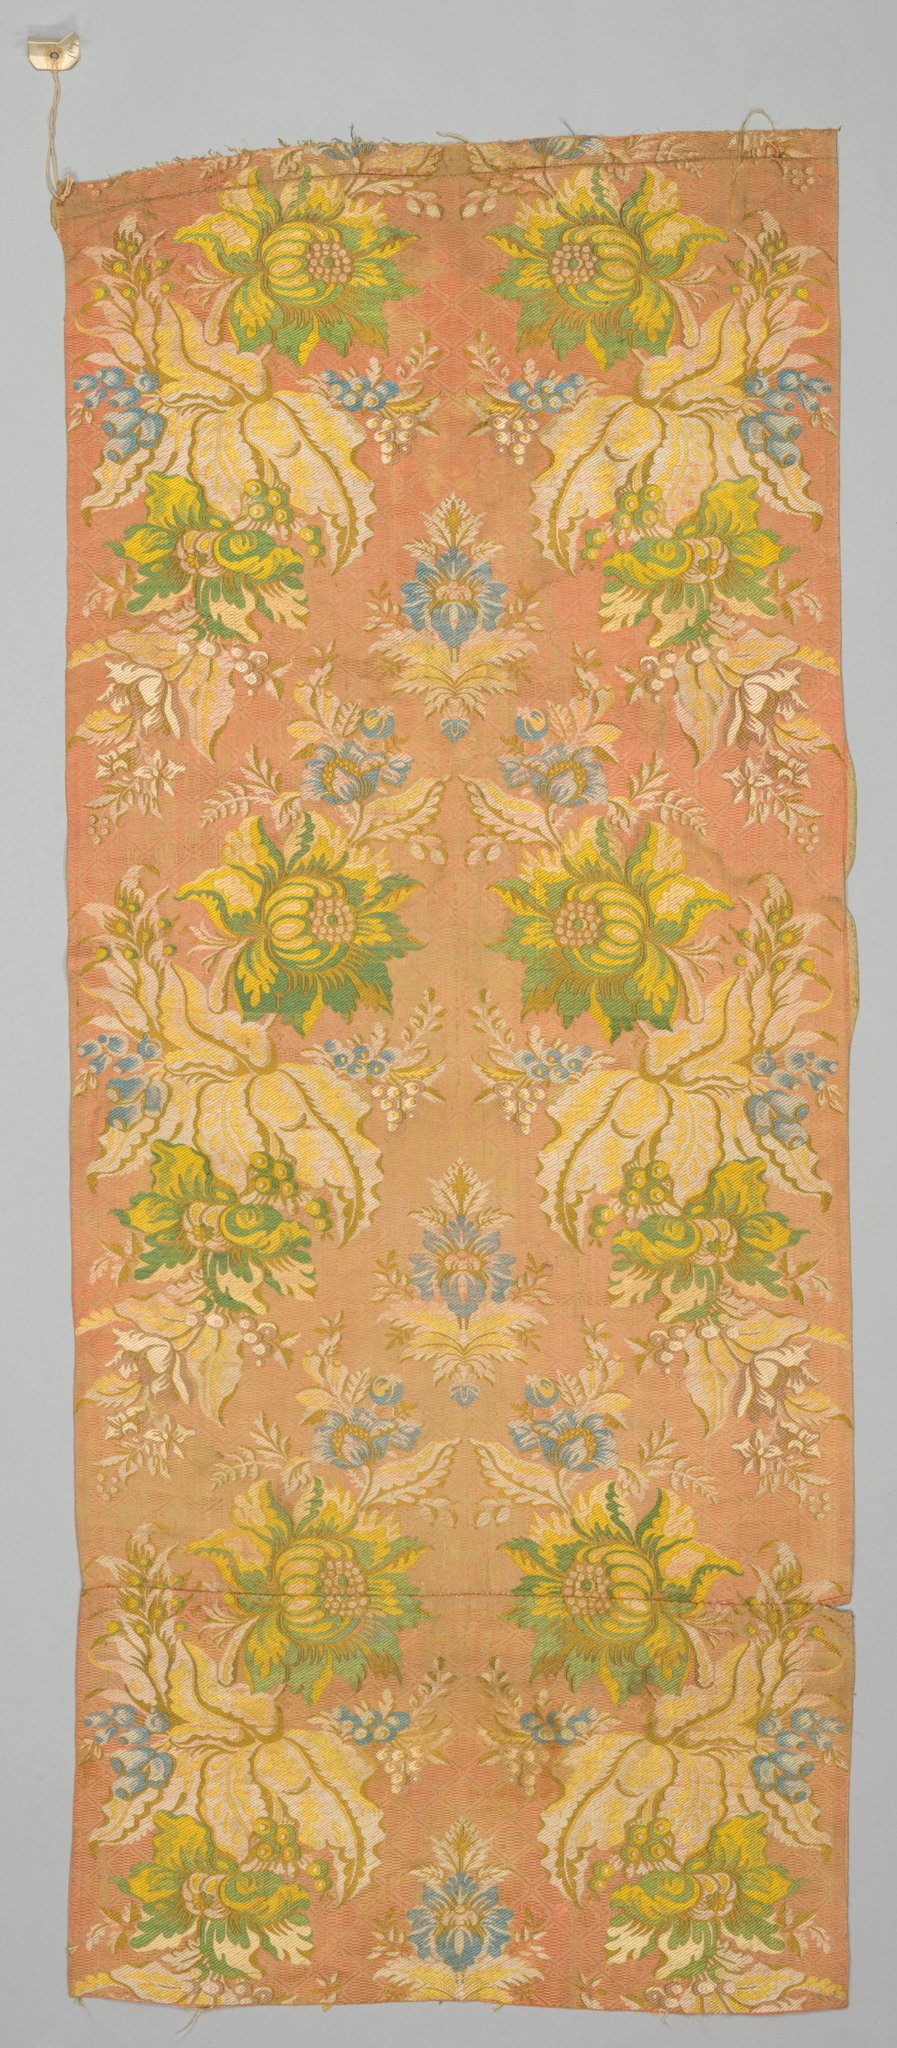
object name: silk textile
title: Baan van twee aan elkaar genaaide zijdeweefsels met bloemdessin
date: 1735-1745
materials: silk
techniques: brocade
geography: france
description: Baan van twee aan elkaar genaaide gelanceerde en gebrocheerde zijdeweefsels, canntillé, liseré. Dessin: paren naar elkaar toegenegen zeer grootschalige arrangementen van bloemen en bladeren waartussen een centraal, kleiner, symmetrische opgebouwd bloemarrangement in geel, mosterdkleur, groen en twee kleuren blauw (brochering) en écru (lancering) op roze fond met liseré-effect in beige. Aan bovenzijde label met 22576 Rose ground Brocade 1 1/3 yrds 35.00 yard. Aan achterzijde op de stof gescheven: 22576. Opgespeld papier met letter Z. Toestand: goed, mat wat versleten.